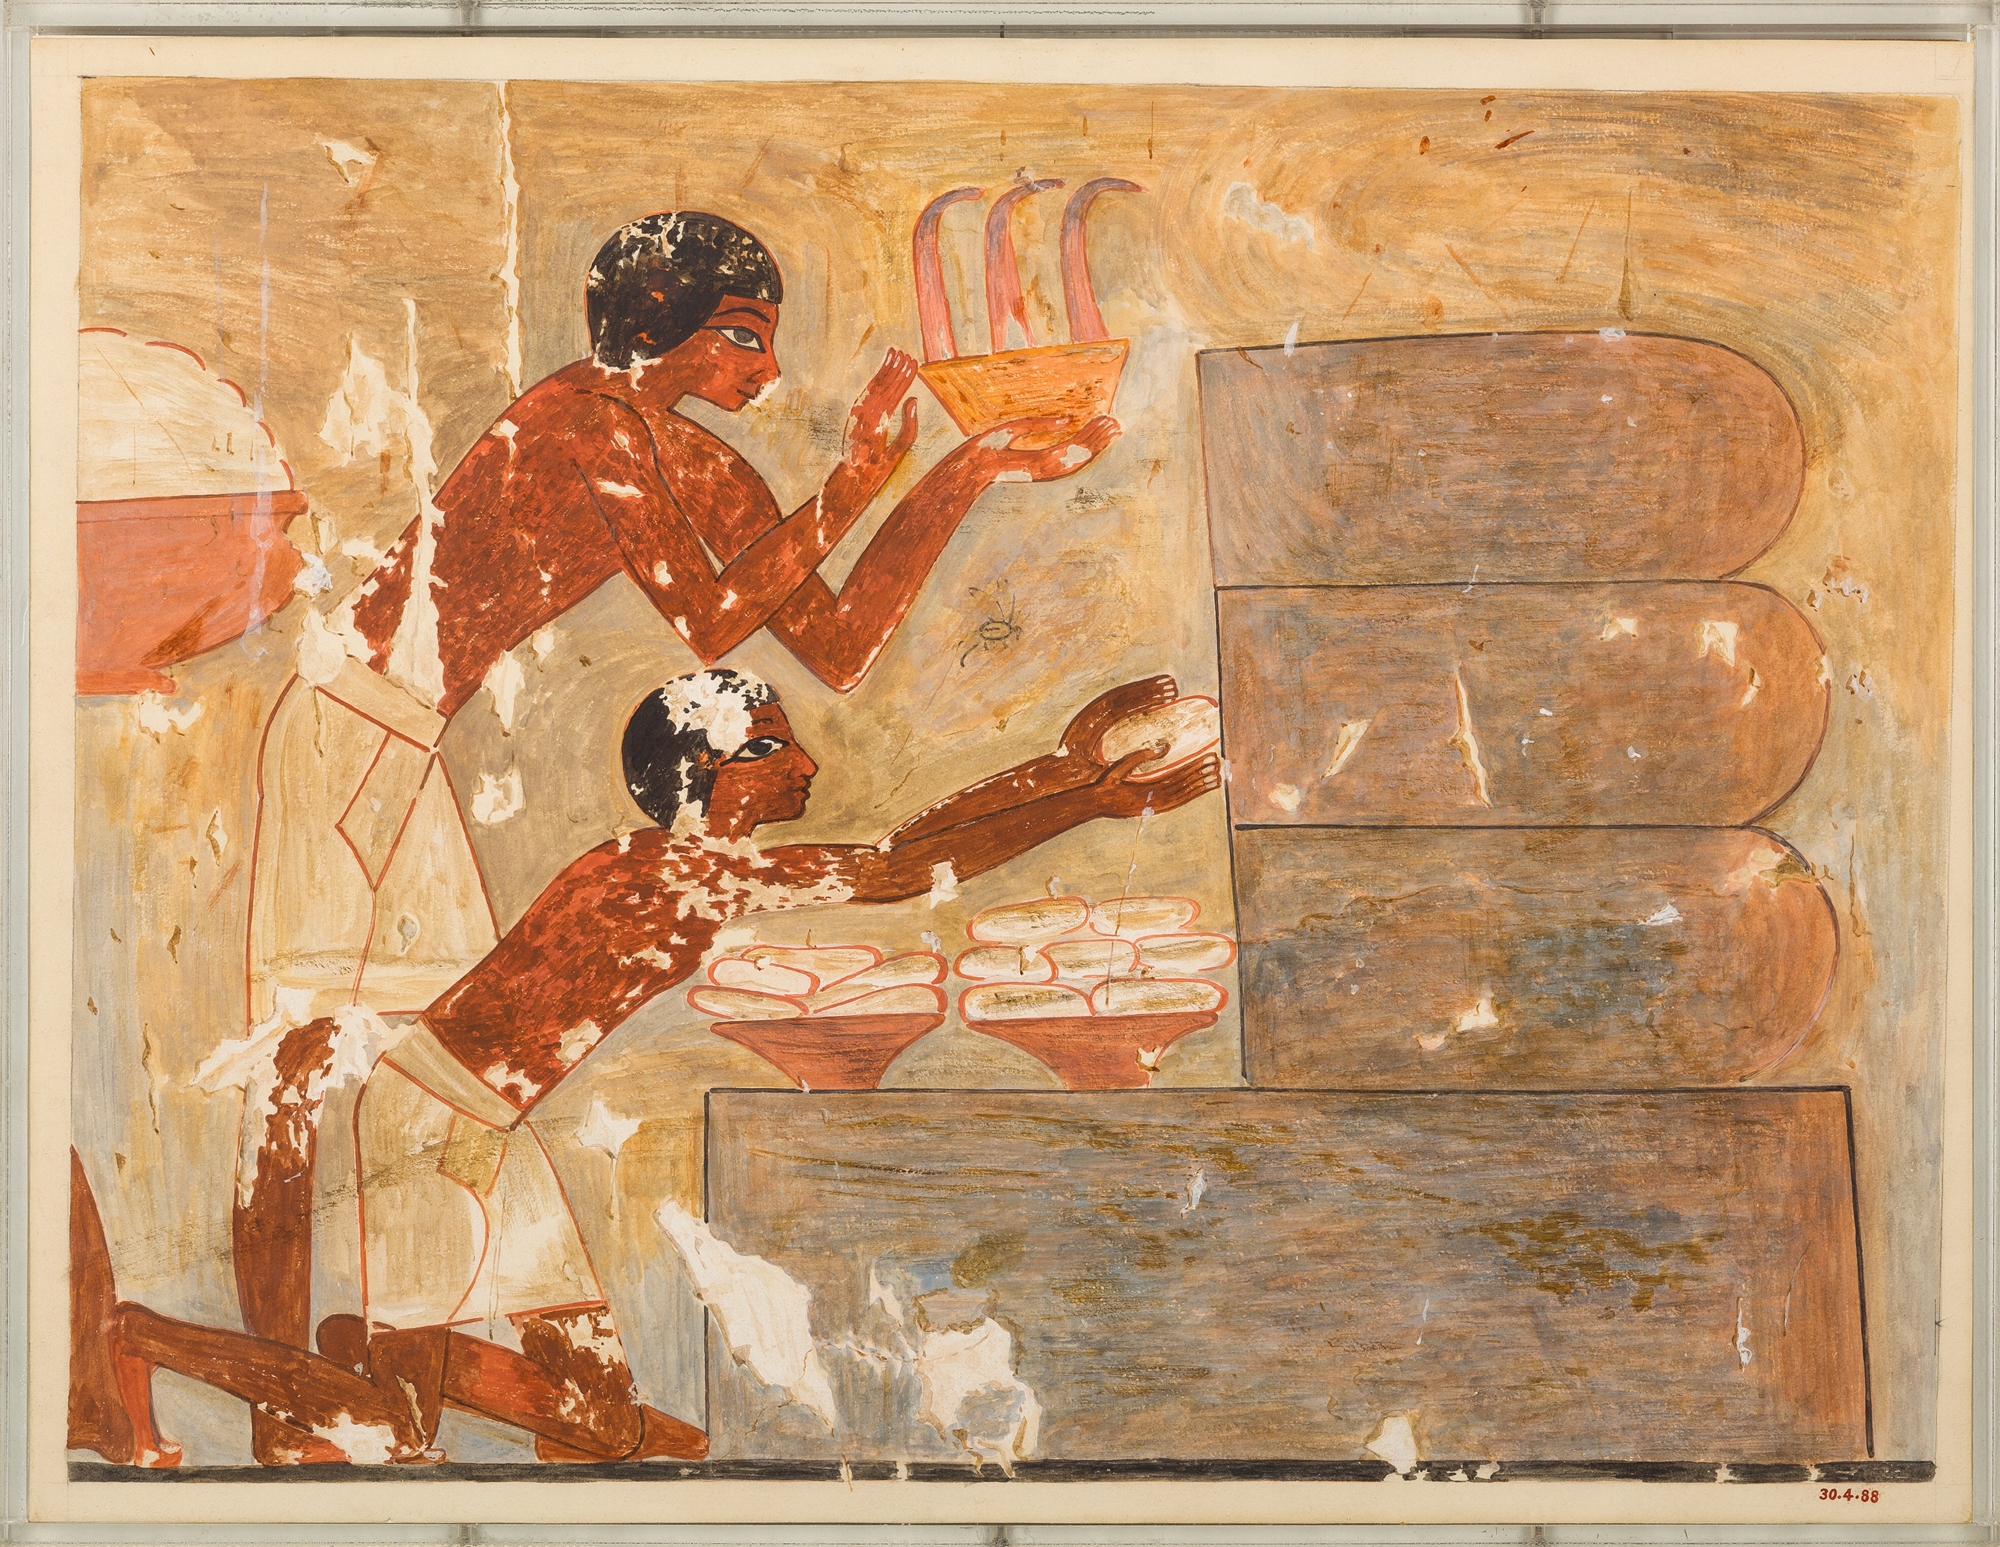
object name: facsimile, rekhmire tt 100, beekeeping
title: Gathering Honey, Tomb of Rekhmire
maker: nina de garis davies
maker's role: artist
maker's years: 1881-1965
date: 1479-1425 BCE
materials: paper, paint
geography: egypt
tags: men,working,rekhmire-exhibition